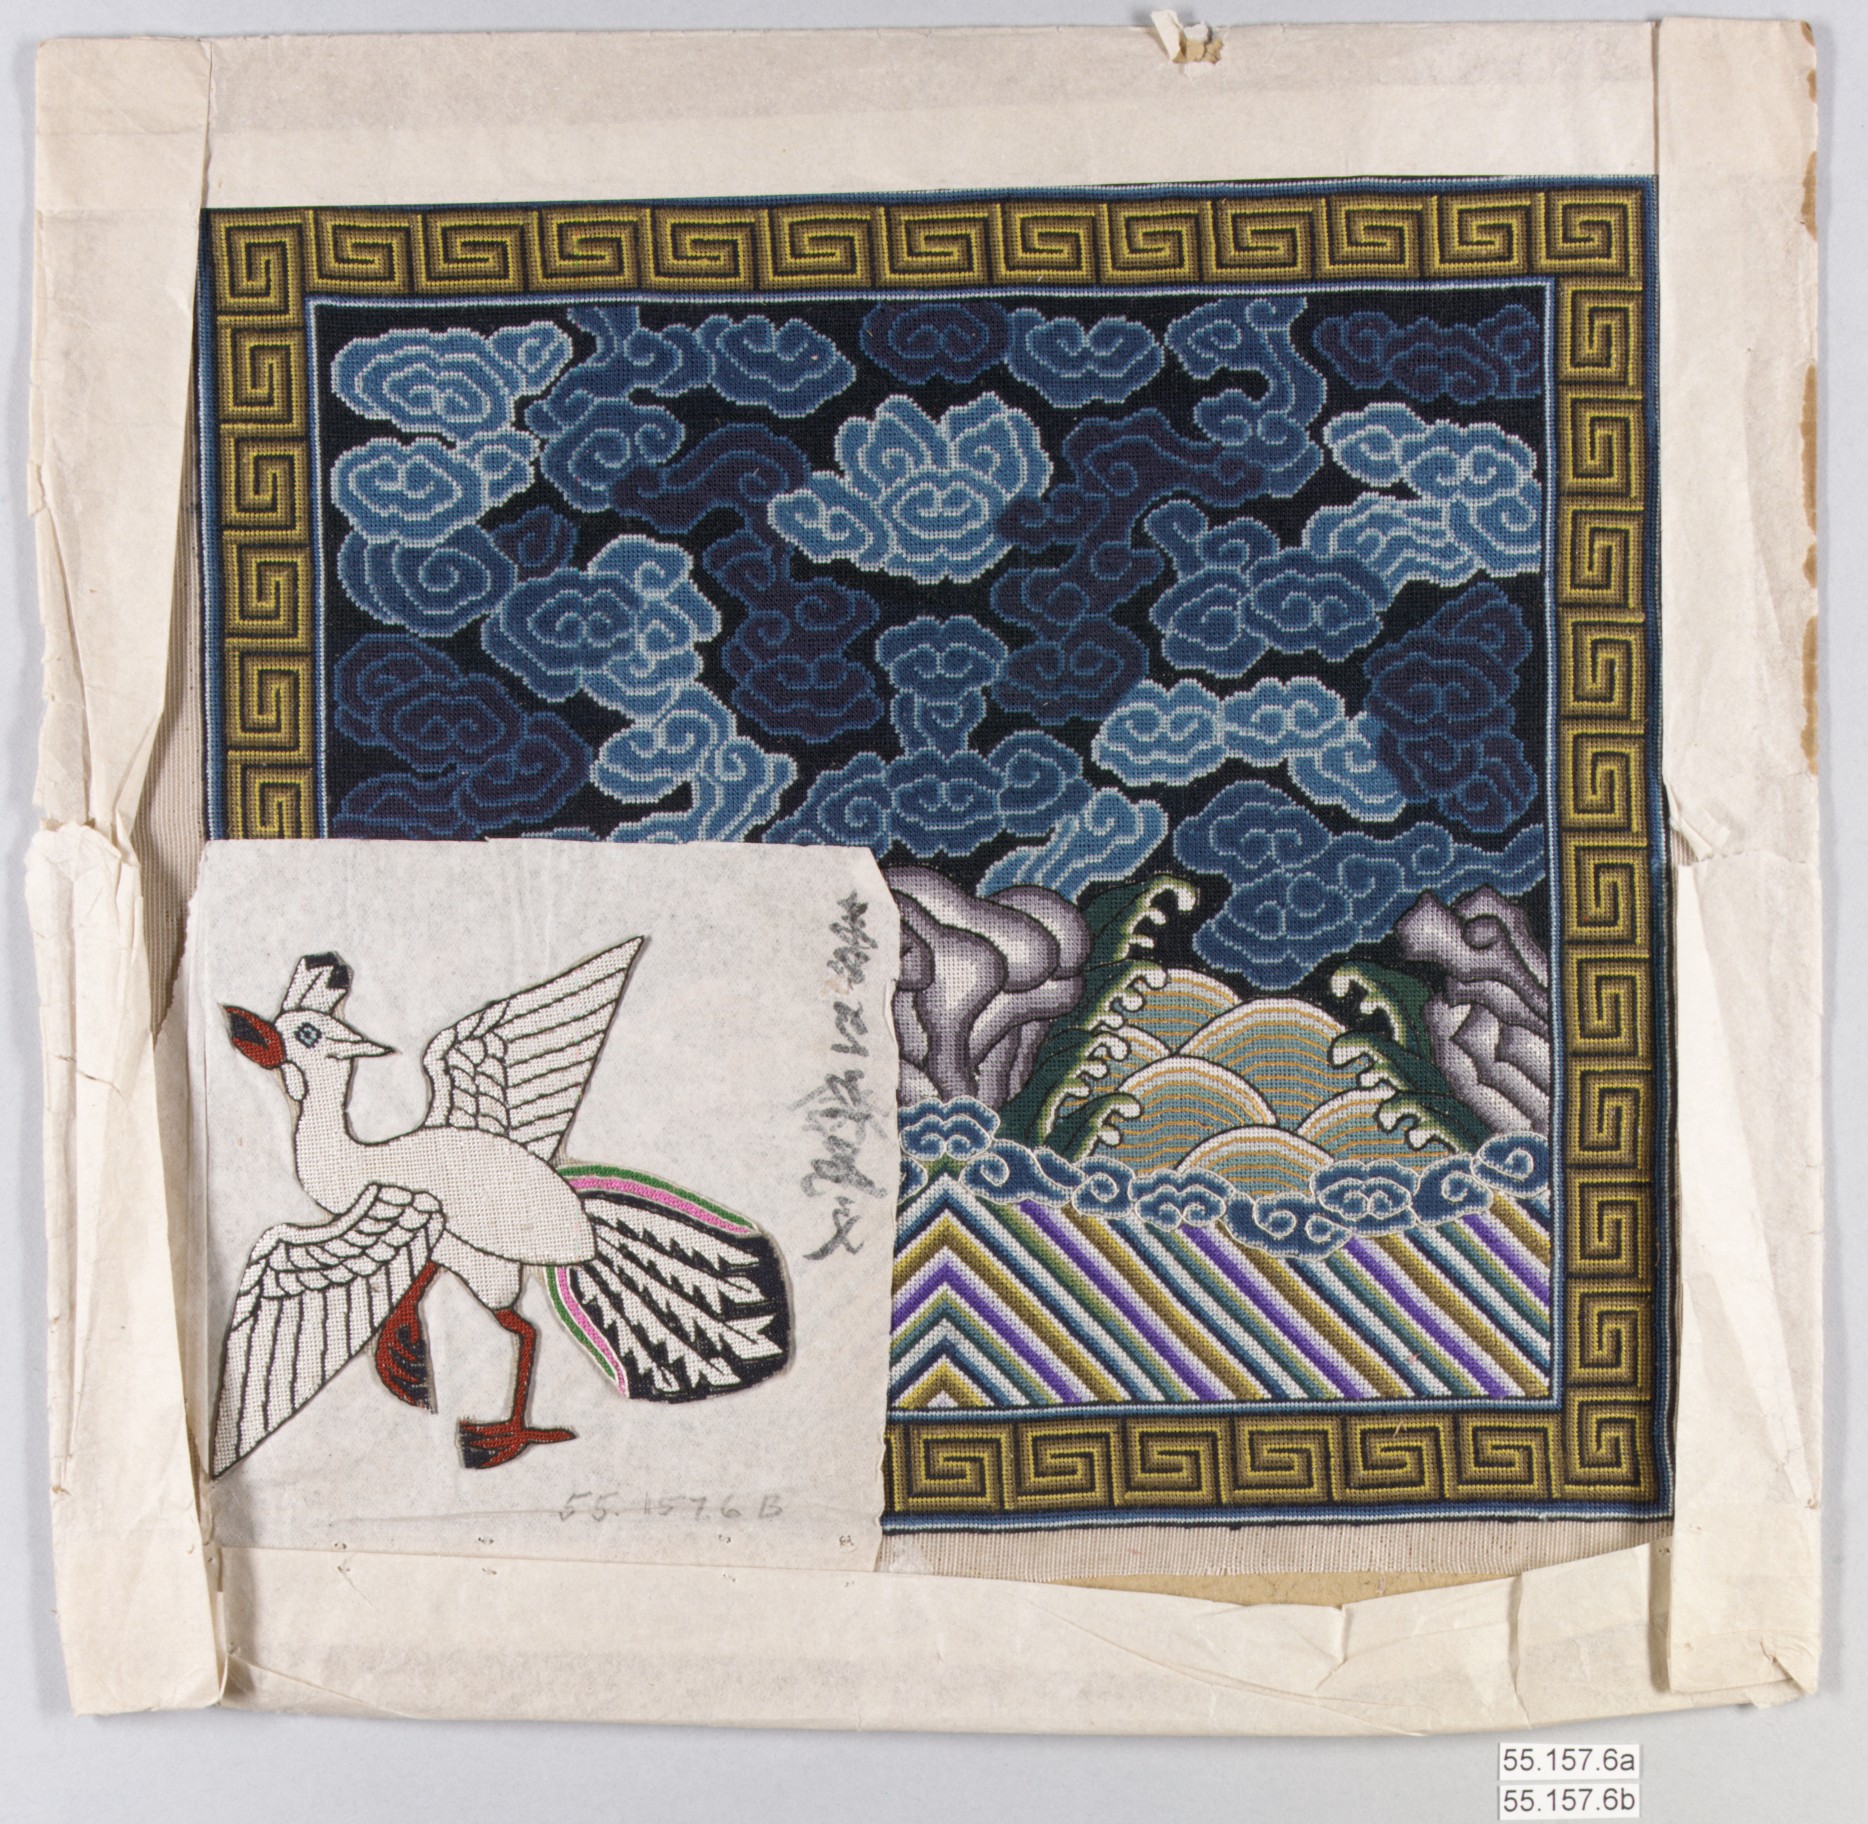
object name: rank badge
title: Rank Badge with Waves, Rocks and Unfinished Appliqué of Silver Pheasant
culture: chinese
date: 1867-1933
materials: metal thread, silk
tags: pheasants